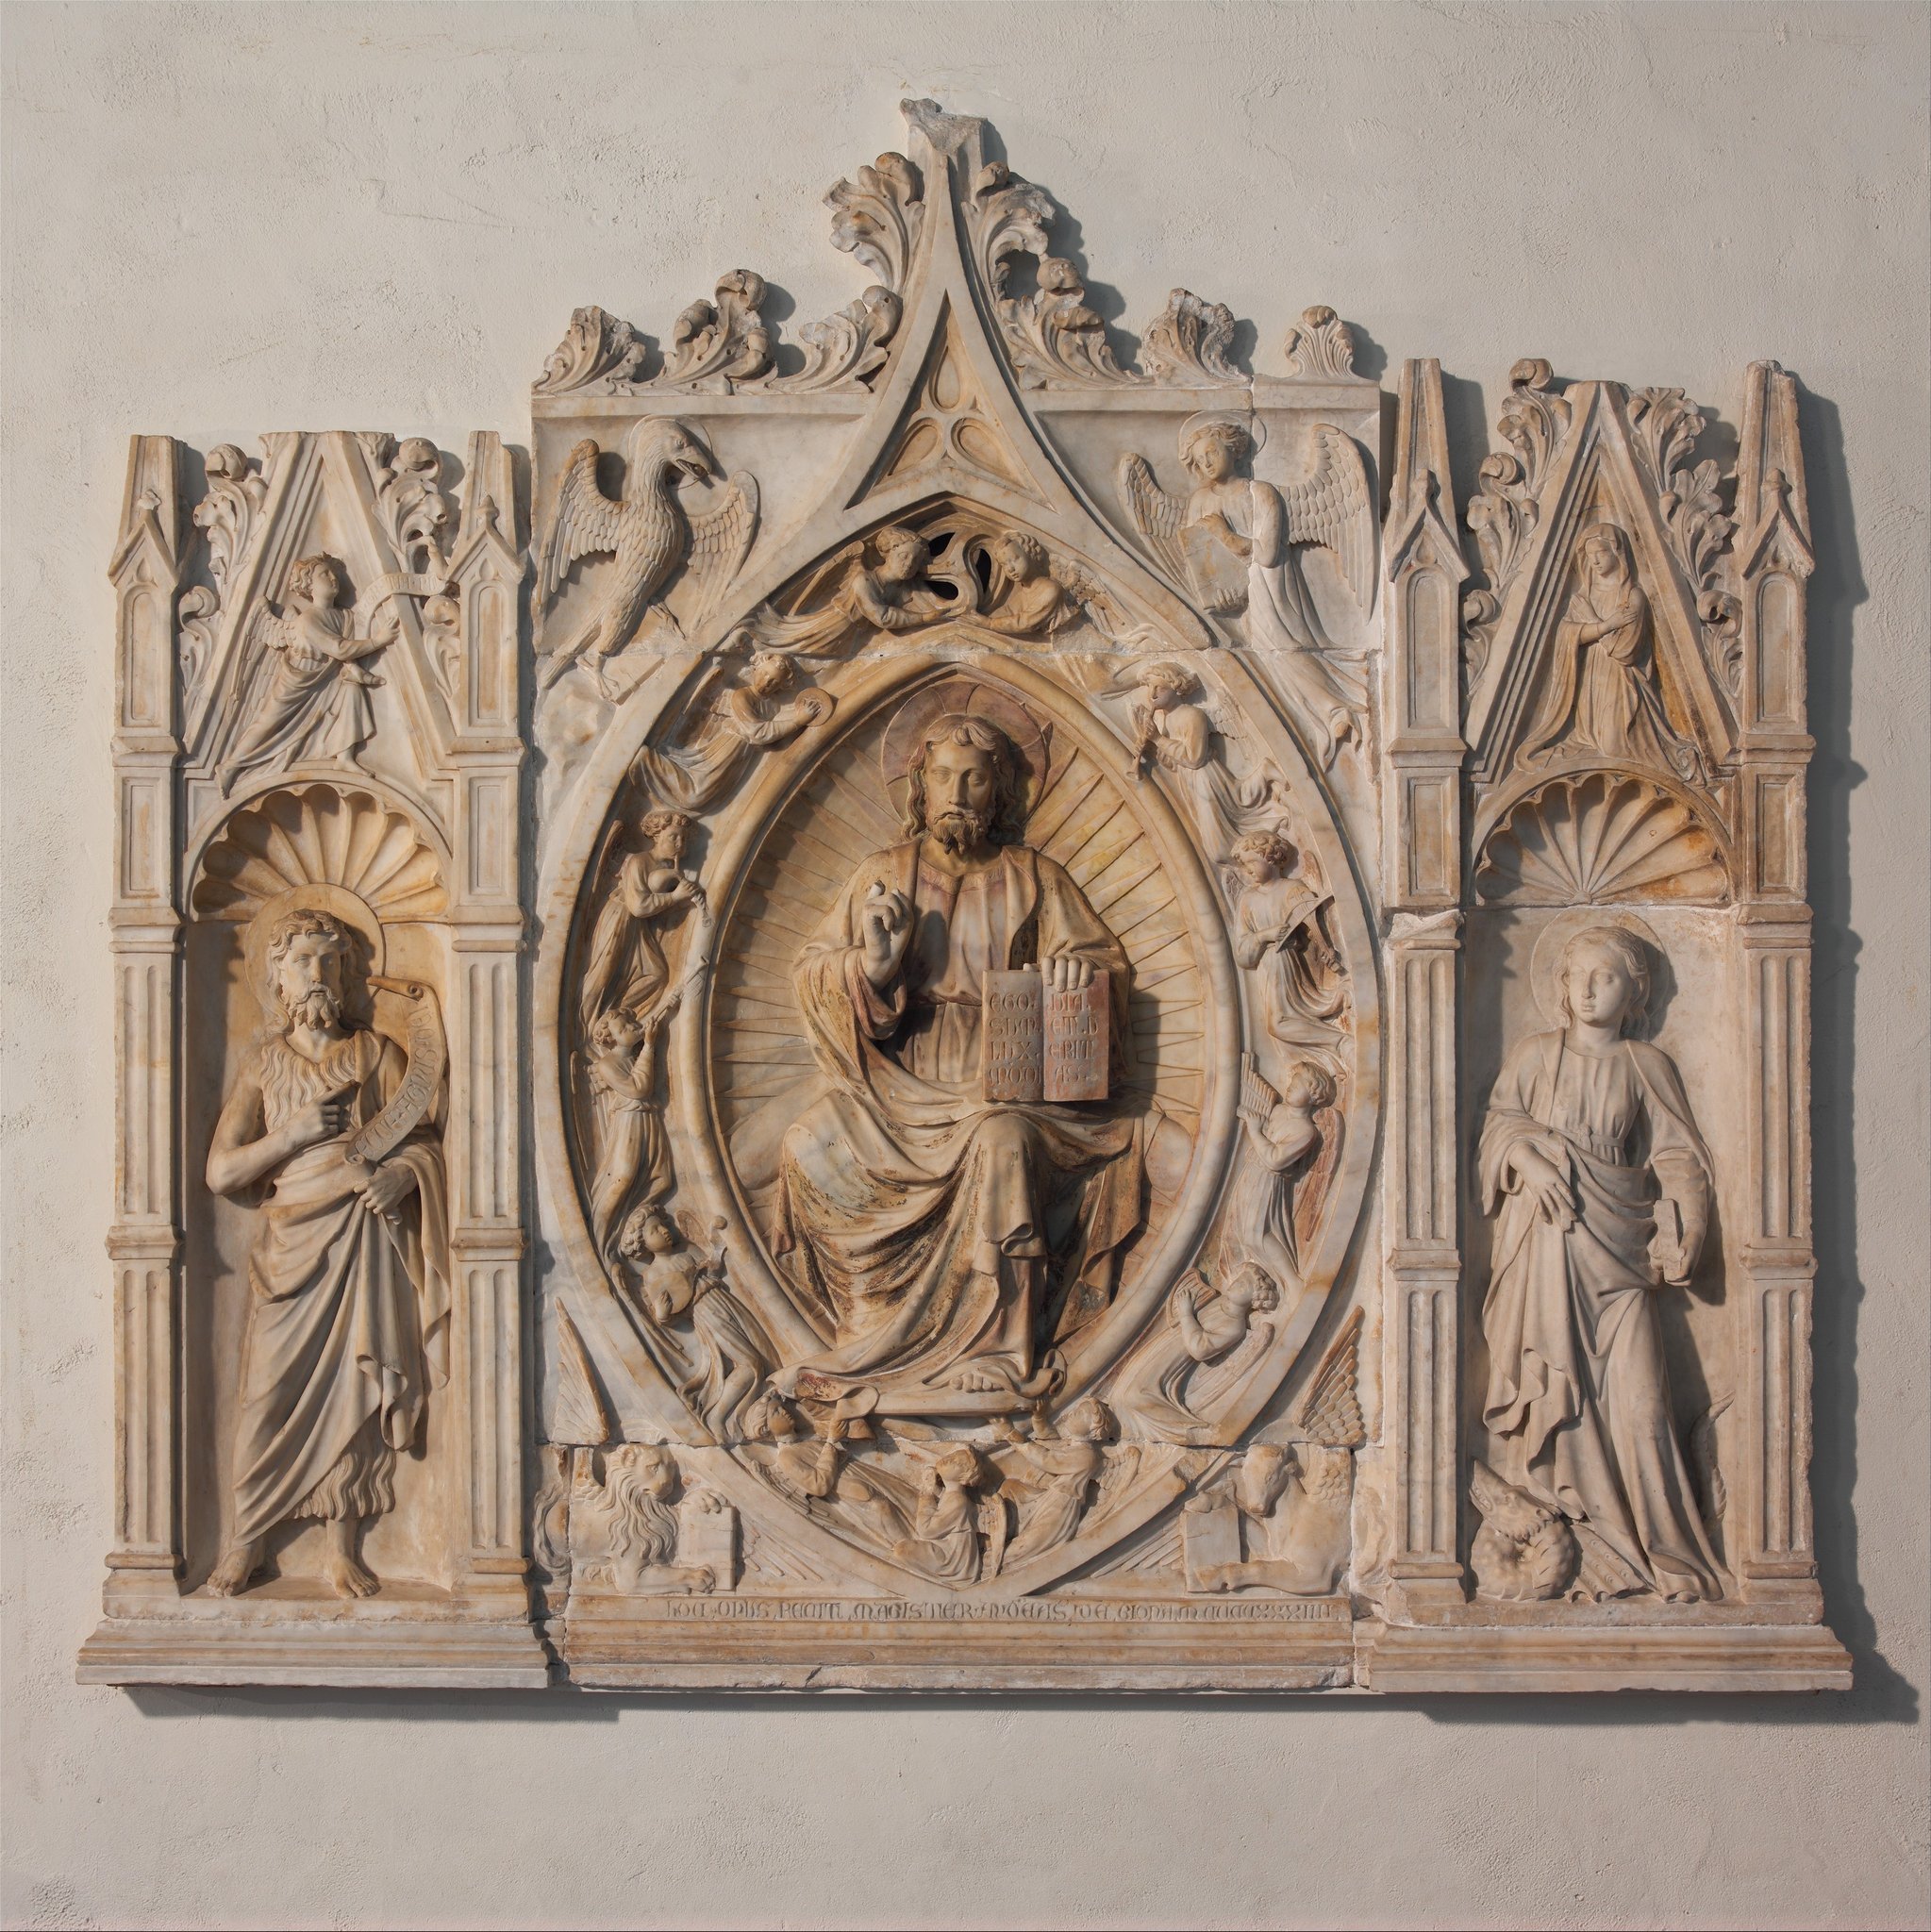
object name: altarpiece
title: Altarpiece with Christ, Saint John the Baptist, and Saint Margaret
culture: italian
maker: andrea da giona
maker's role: artist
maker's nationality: italian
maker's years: 1434-1450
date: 1434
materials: marble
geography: italy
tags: angels,christ,saint john the baptist